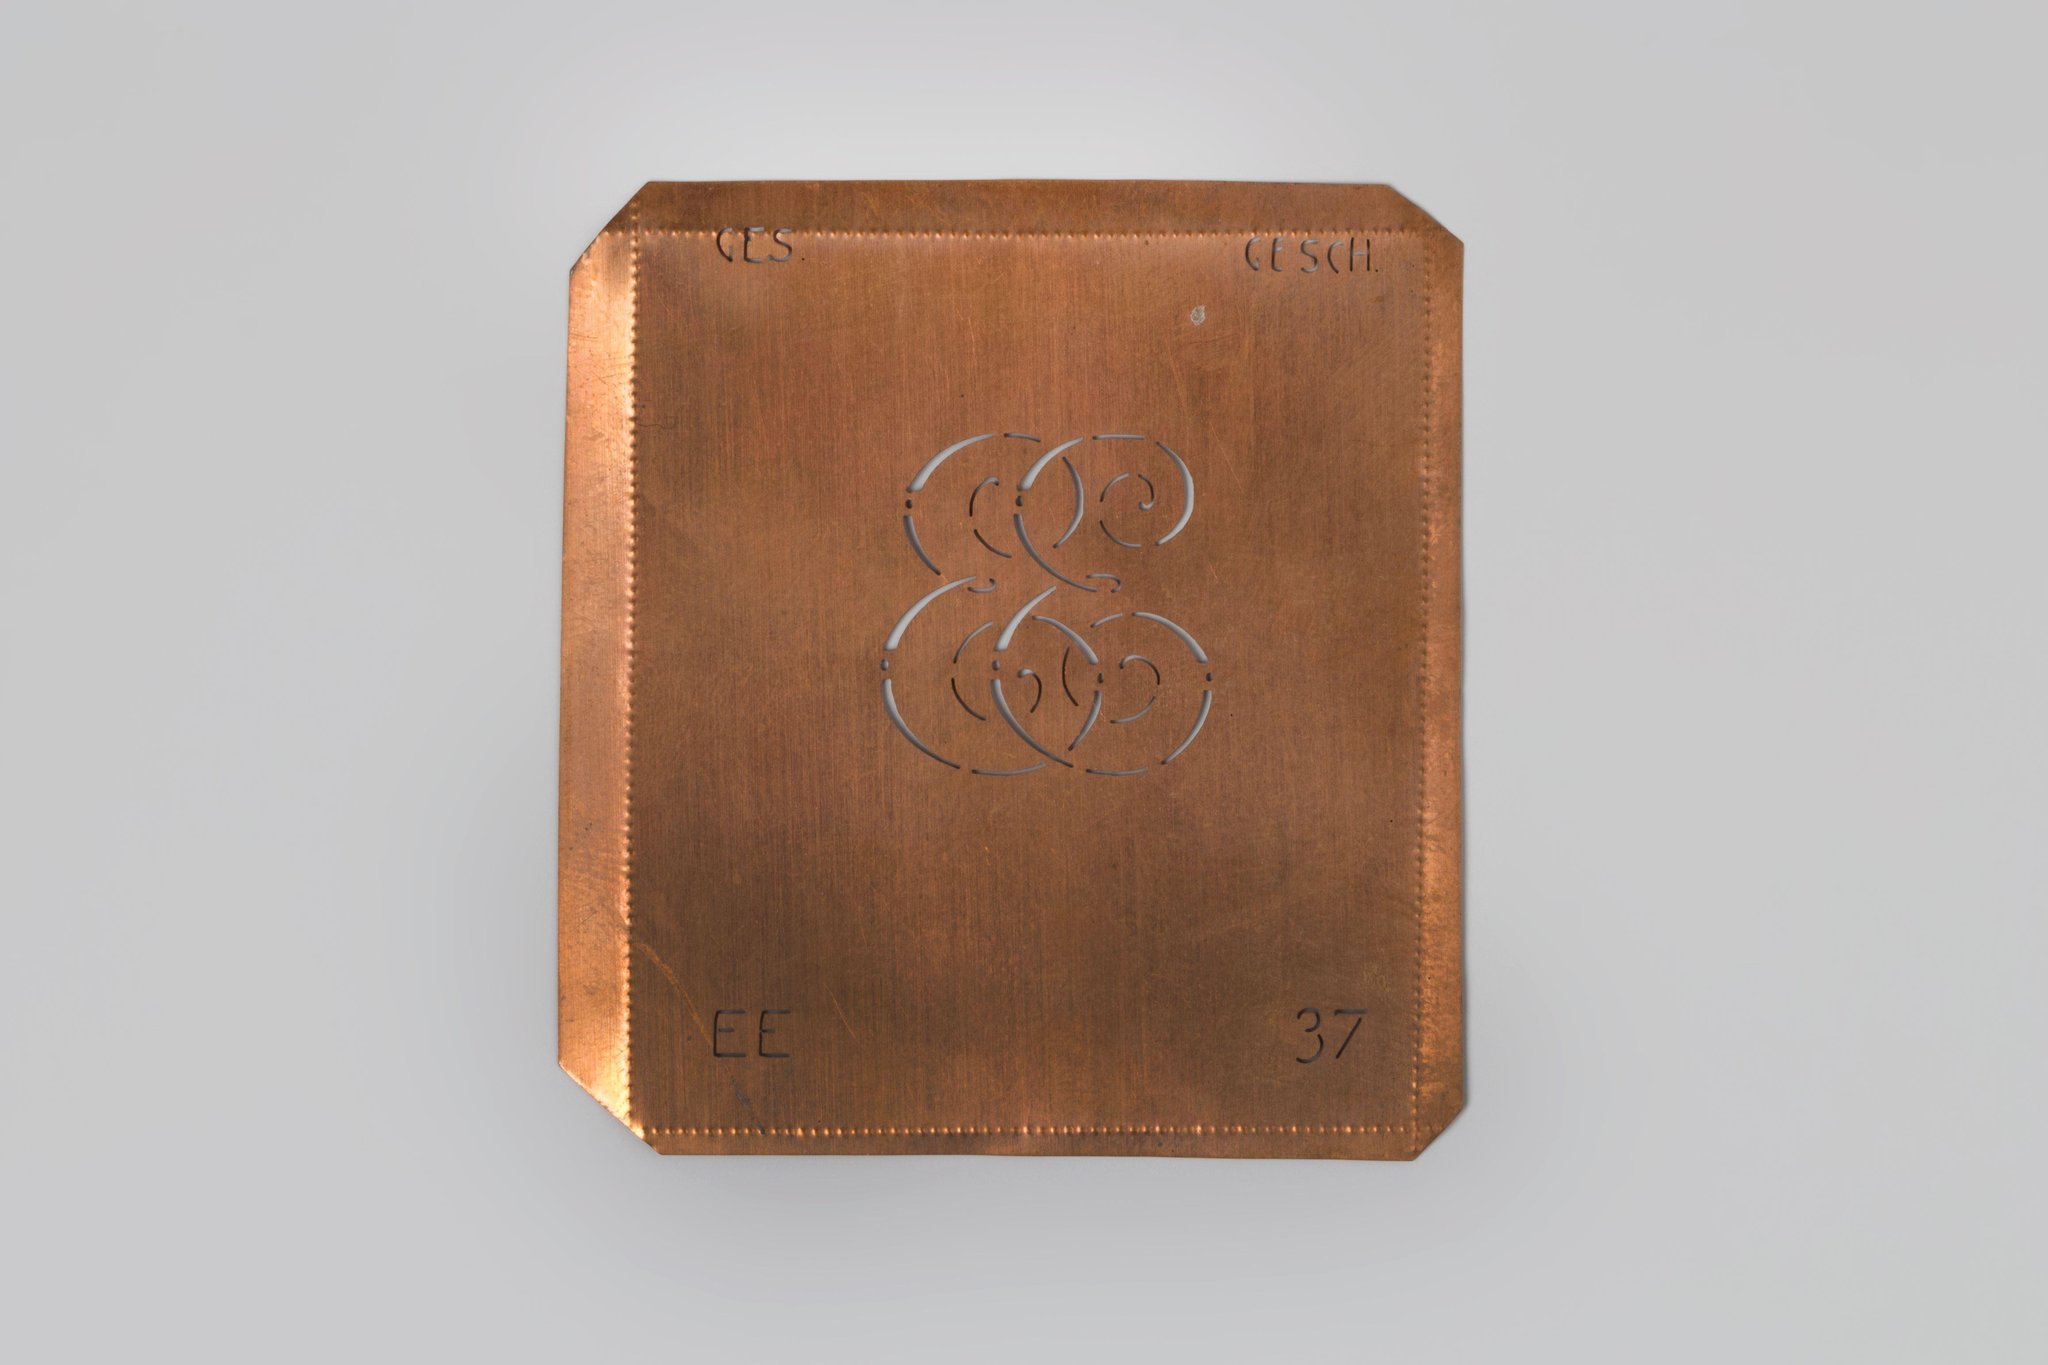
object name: handwerkgerei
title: Sjabloon van rood koper, rechthoekig, met uitgestanste initialen 'EE', zeer fijn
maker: Anonymous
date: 1900-1925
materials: copper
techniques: manufacturing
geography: netherlands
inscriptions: initials: ‘'EE'’, inscription: ‘'GES', 'GESCH', 'EE' en '37'’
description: Sjabloon van rood koper, voor initiaal 'EE'. Rechthoekig, met vouwrandjes en de calligrafische letters uitgelegd onderaan. Zeer fijn.